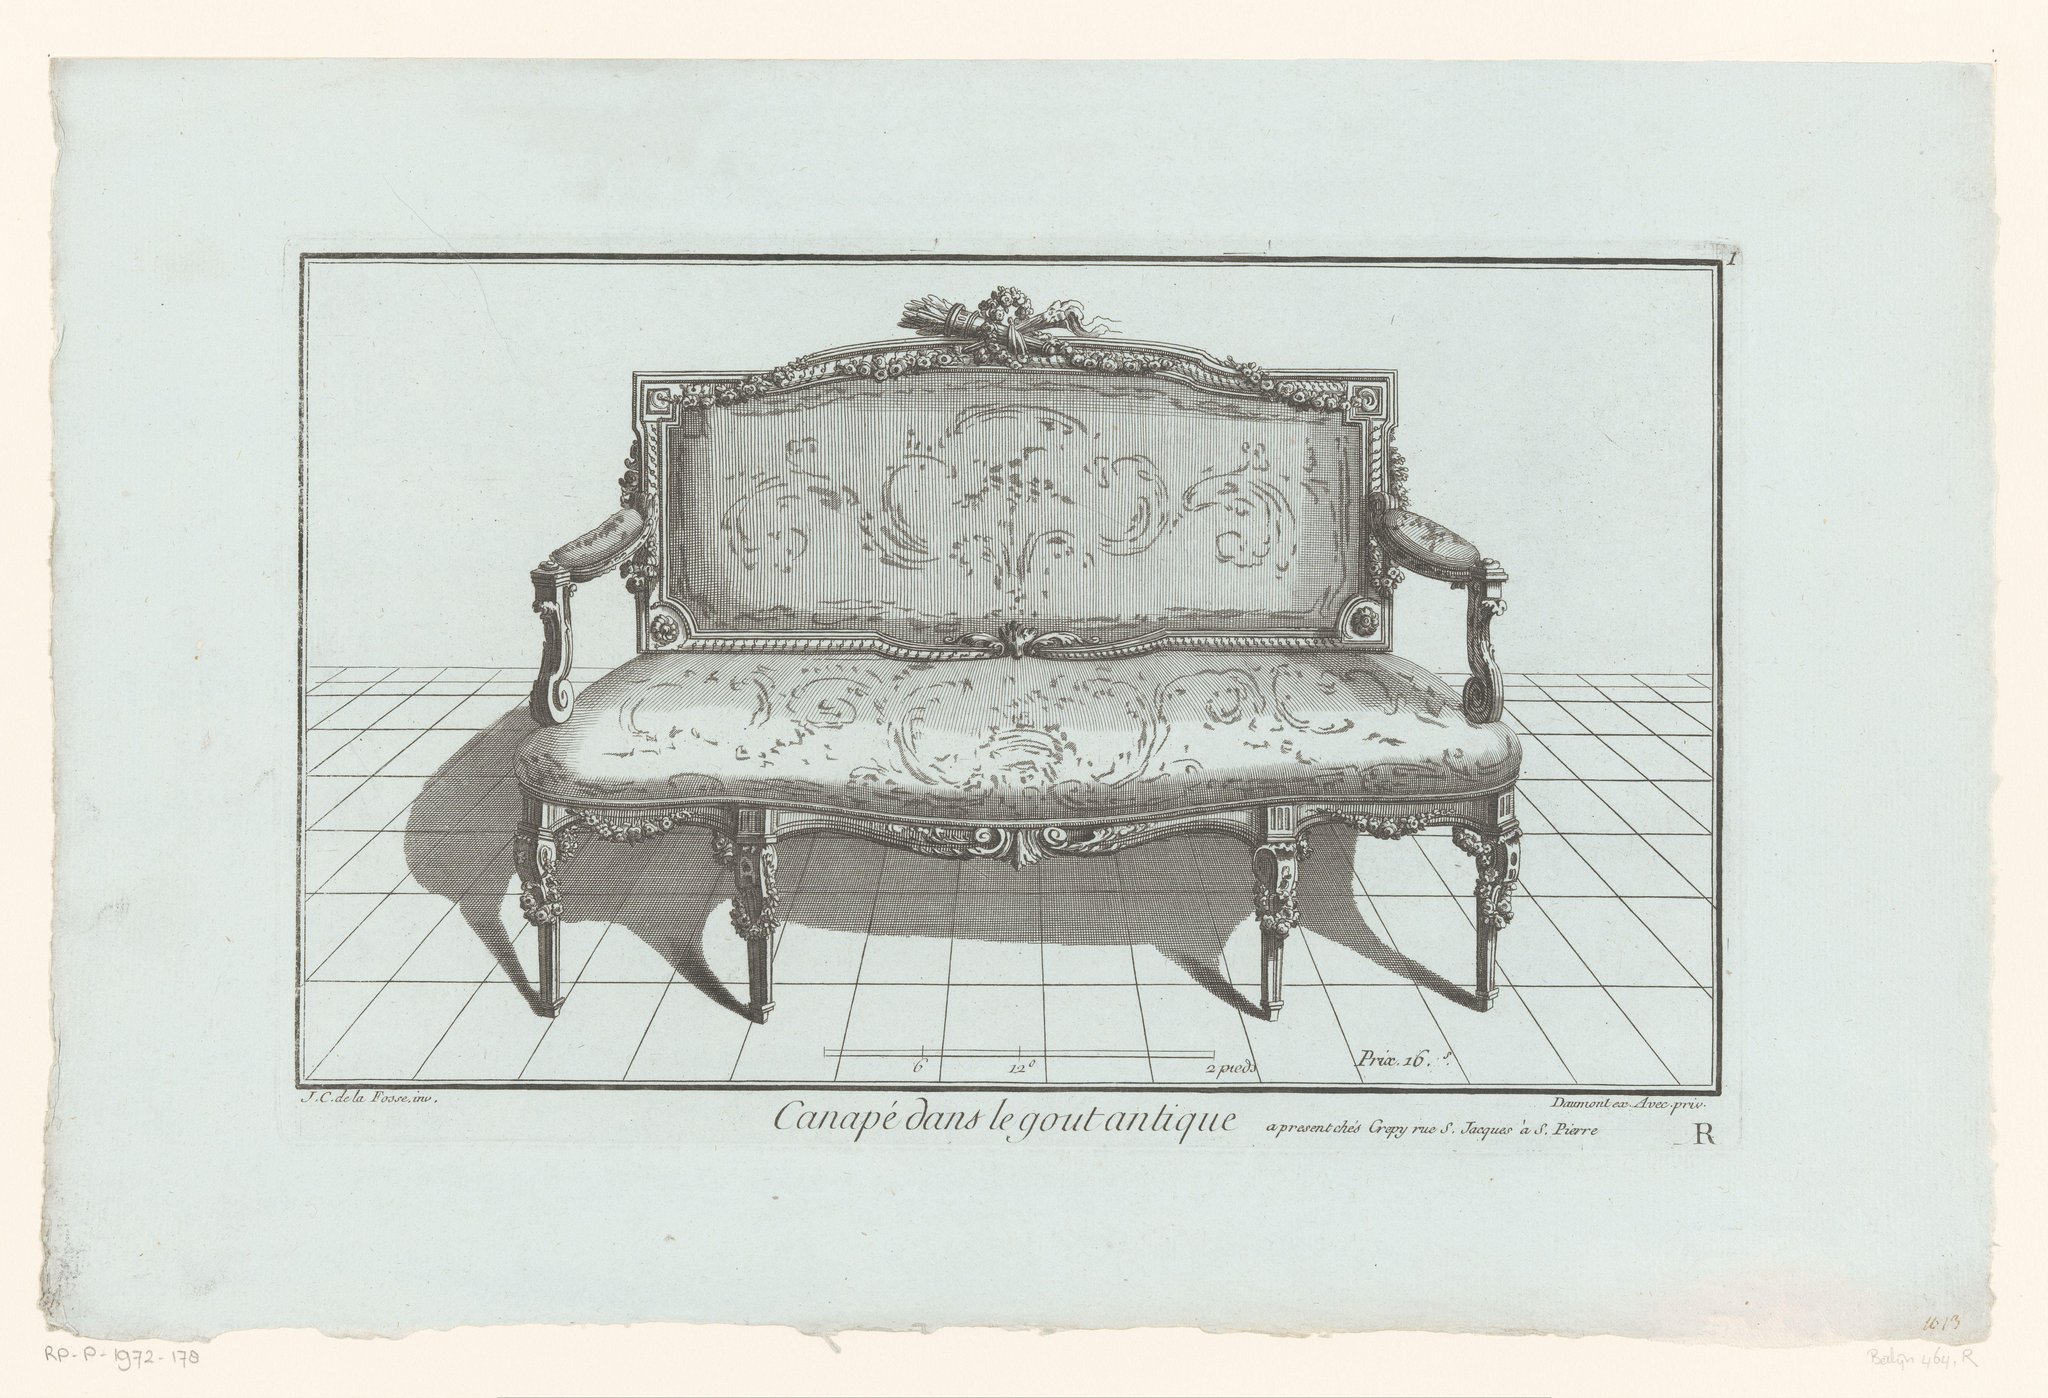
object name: ornament print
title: Bank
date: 1753-1775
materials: paper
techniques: engraving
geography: paris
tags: bench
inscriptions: collector's mark: Lugt 2760, collector's mark: Lugt 2228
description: Een bank met armleuningen, guirlandes en een trofee met pijlenkoker, fakkel en bloemenkrans.